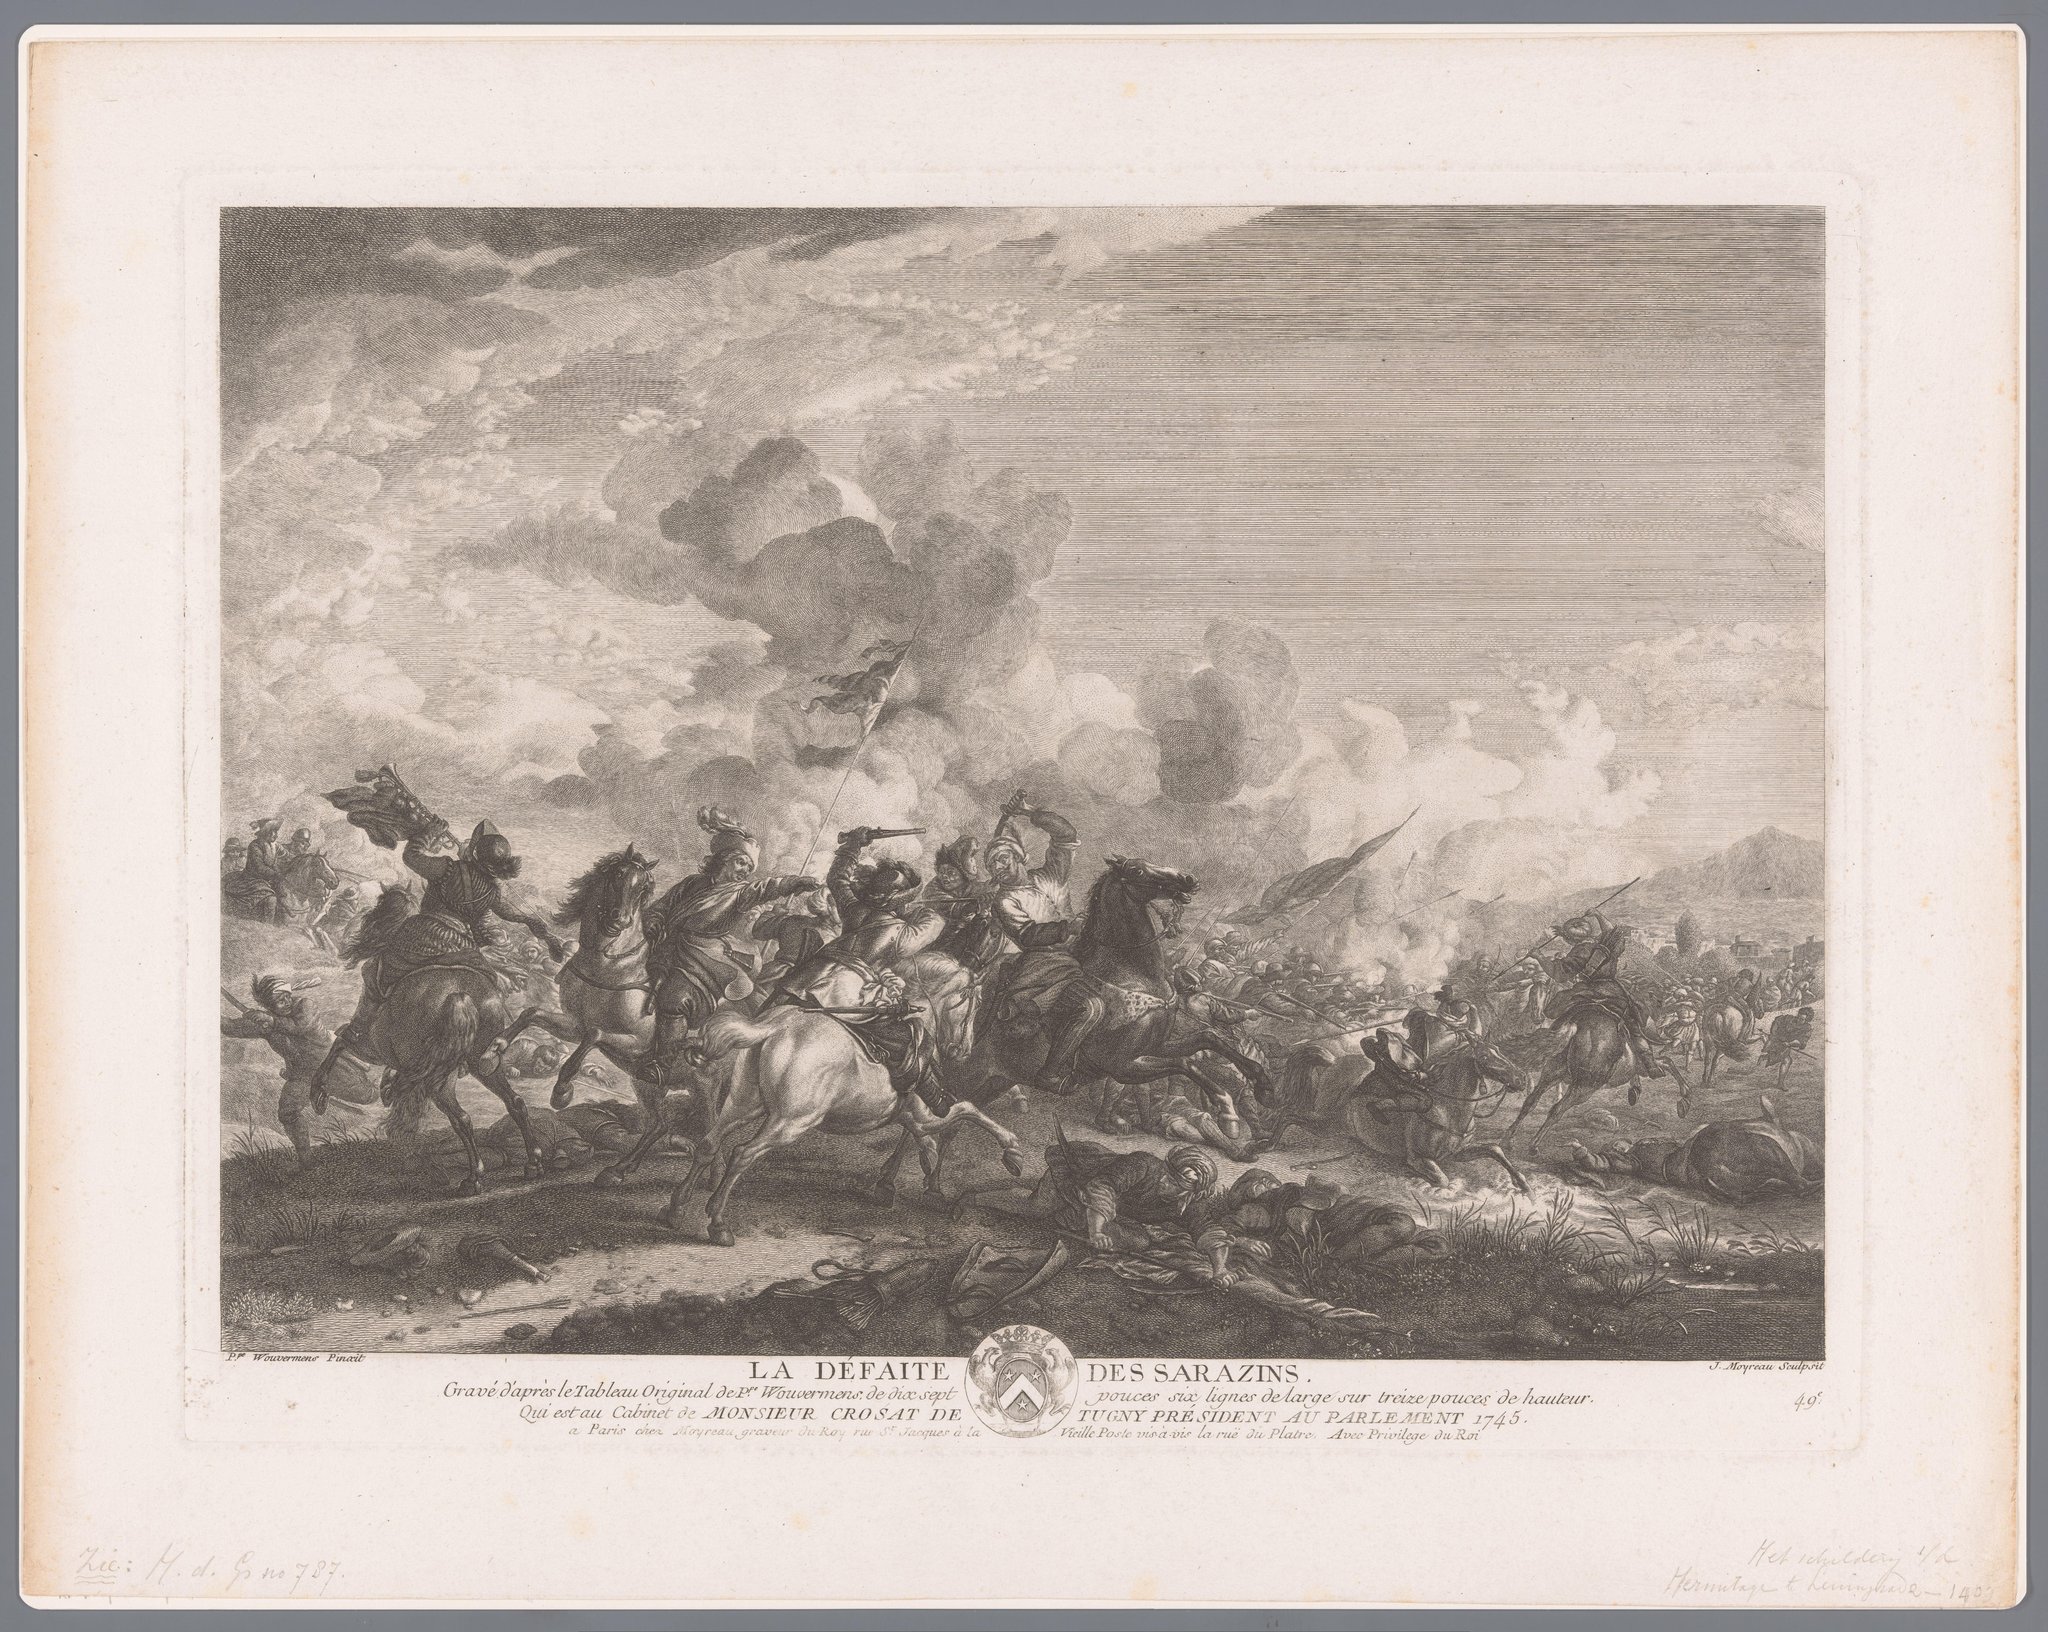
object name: print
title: Oeuvres de Ph.pe Wouwermans Hollandois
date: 1745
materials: paper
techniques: engraving, etching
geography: france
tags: battle (+ cavalry, horsemen)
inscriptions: collector's mark: Lugt 2228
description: Maakt deel uit van een serie van 89 prenten te dateren tussen ca. 1733-1762, naar het geschilderde oeuvre van Philips Wouwerman.